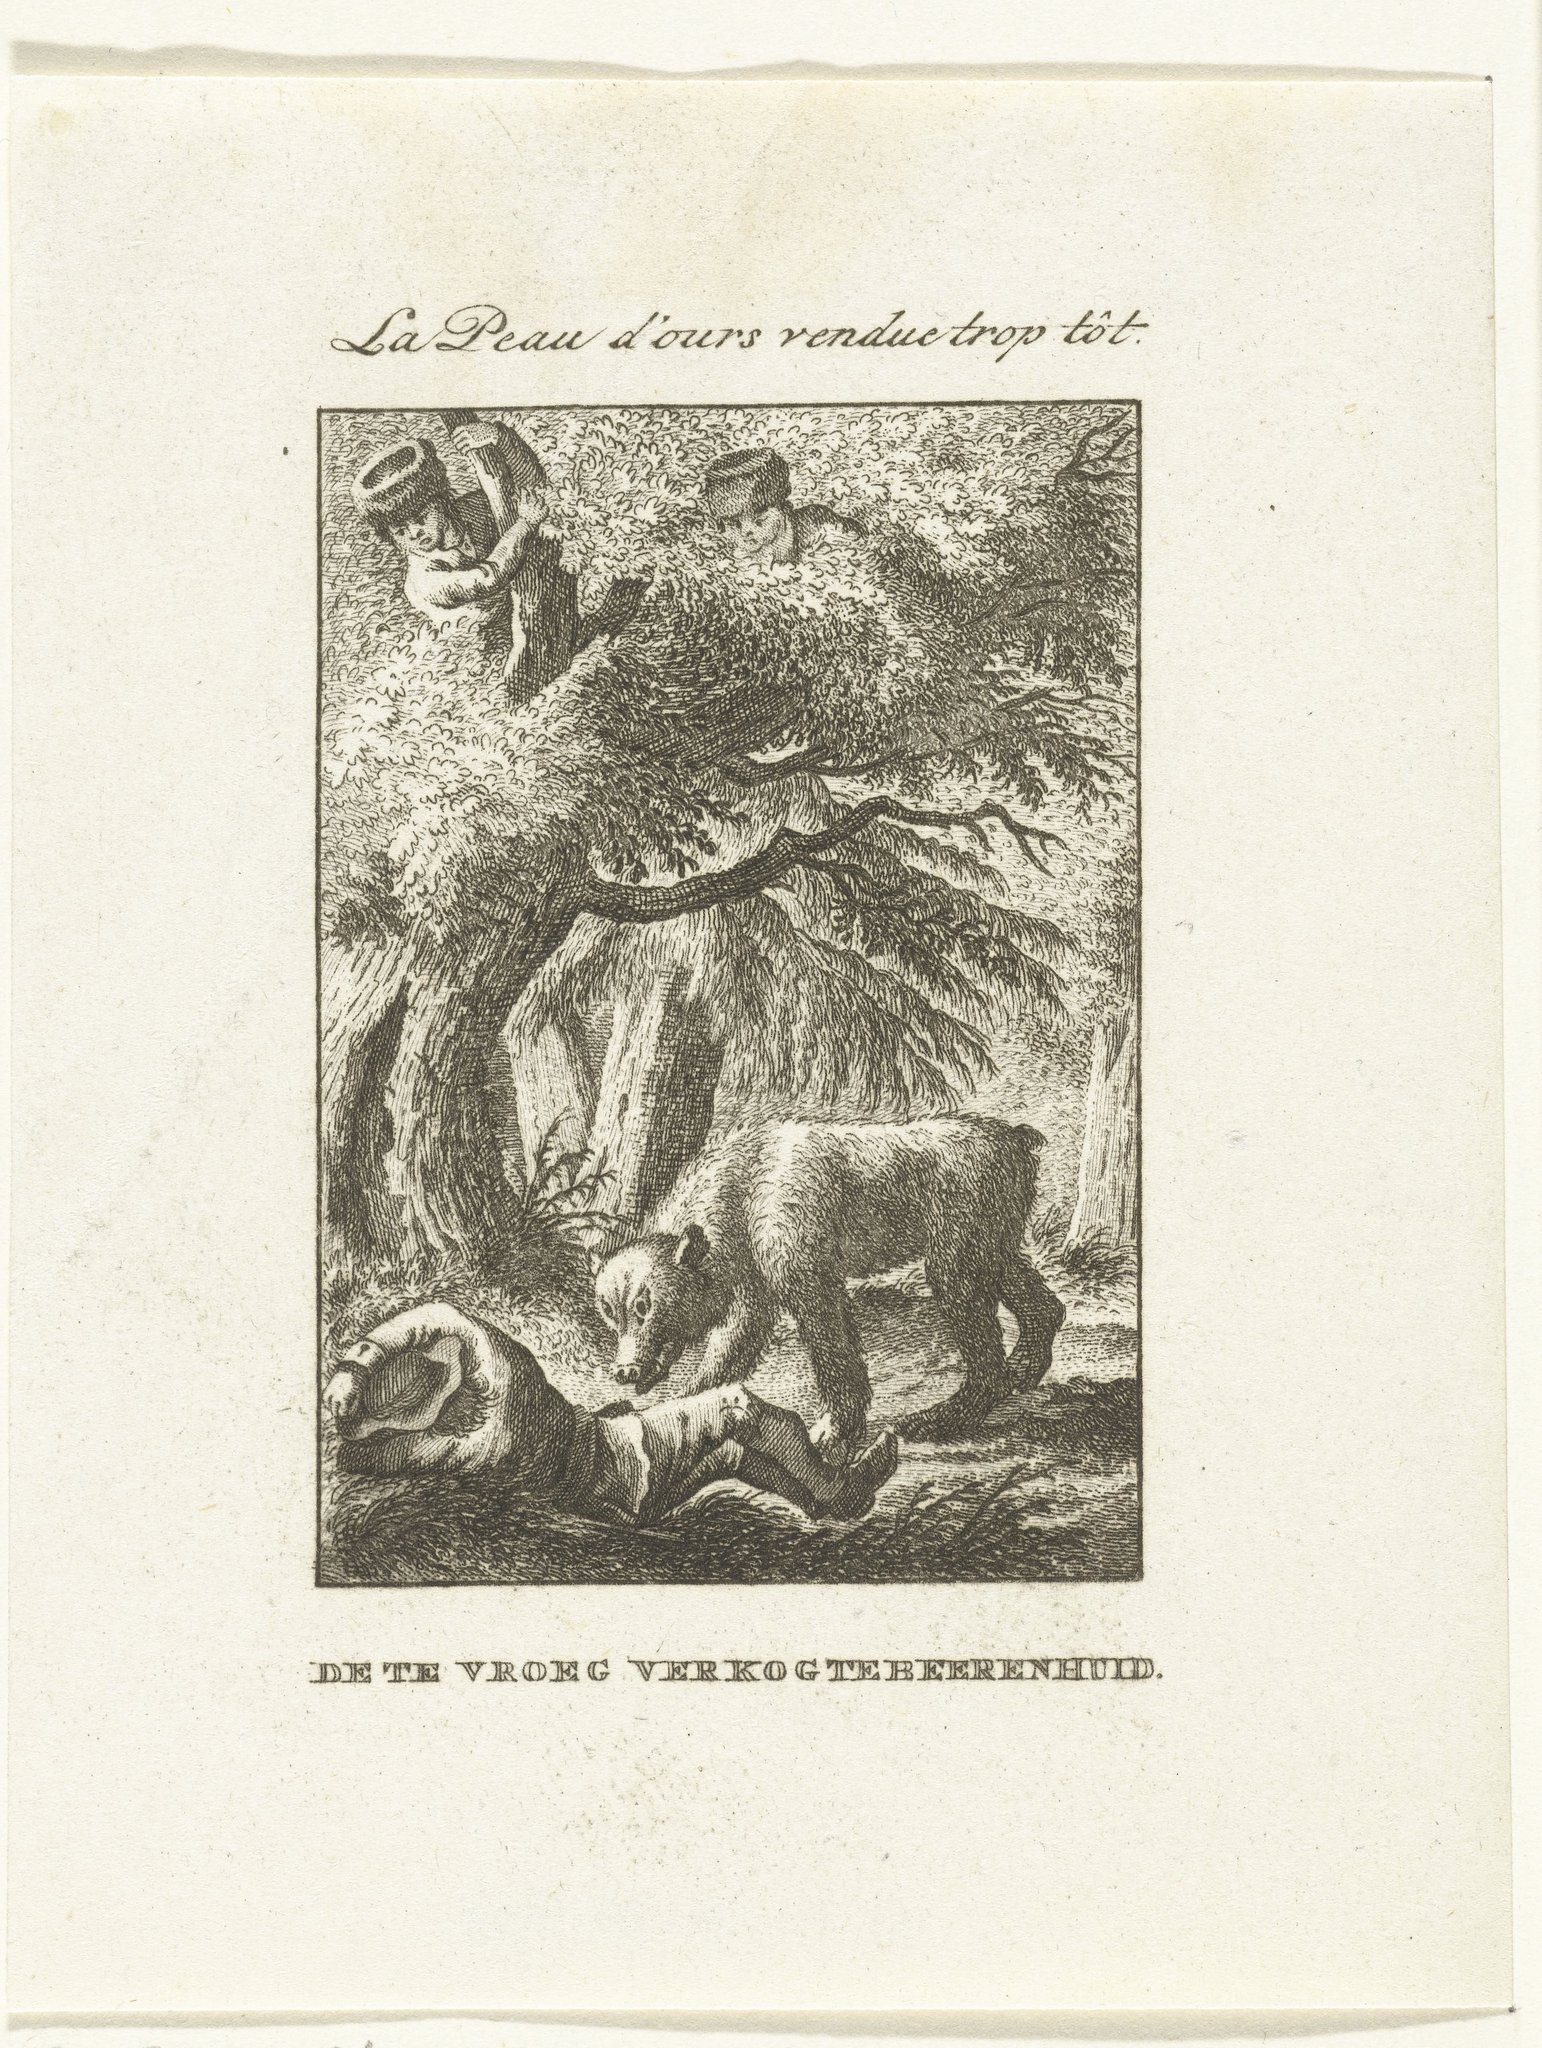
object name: print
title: La peau d'ours vendue trop tôt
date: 1781-1799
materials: paper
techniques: etching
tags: beasts of prey, predatory animals: bear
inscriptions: collector's mark: Lugt 2228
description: Verbeelding van het spreekwoord: De huid niet verkopen voordat de beer geschoten is. De jongen op de grond heeft blijkbaar te snel gehandeld waardoor hij nu in de problemen zit. De twee jongens in de boom volgen angstig wat er gaat gebeuren.